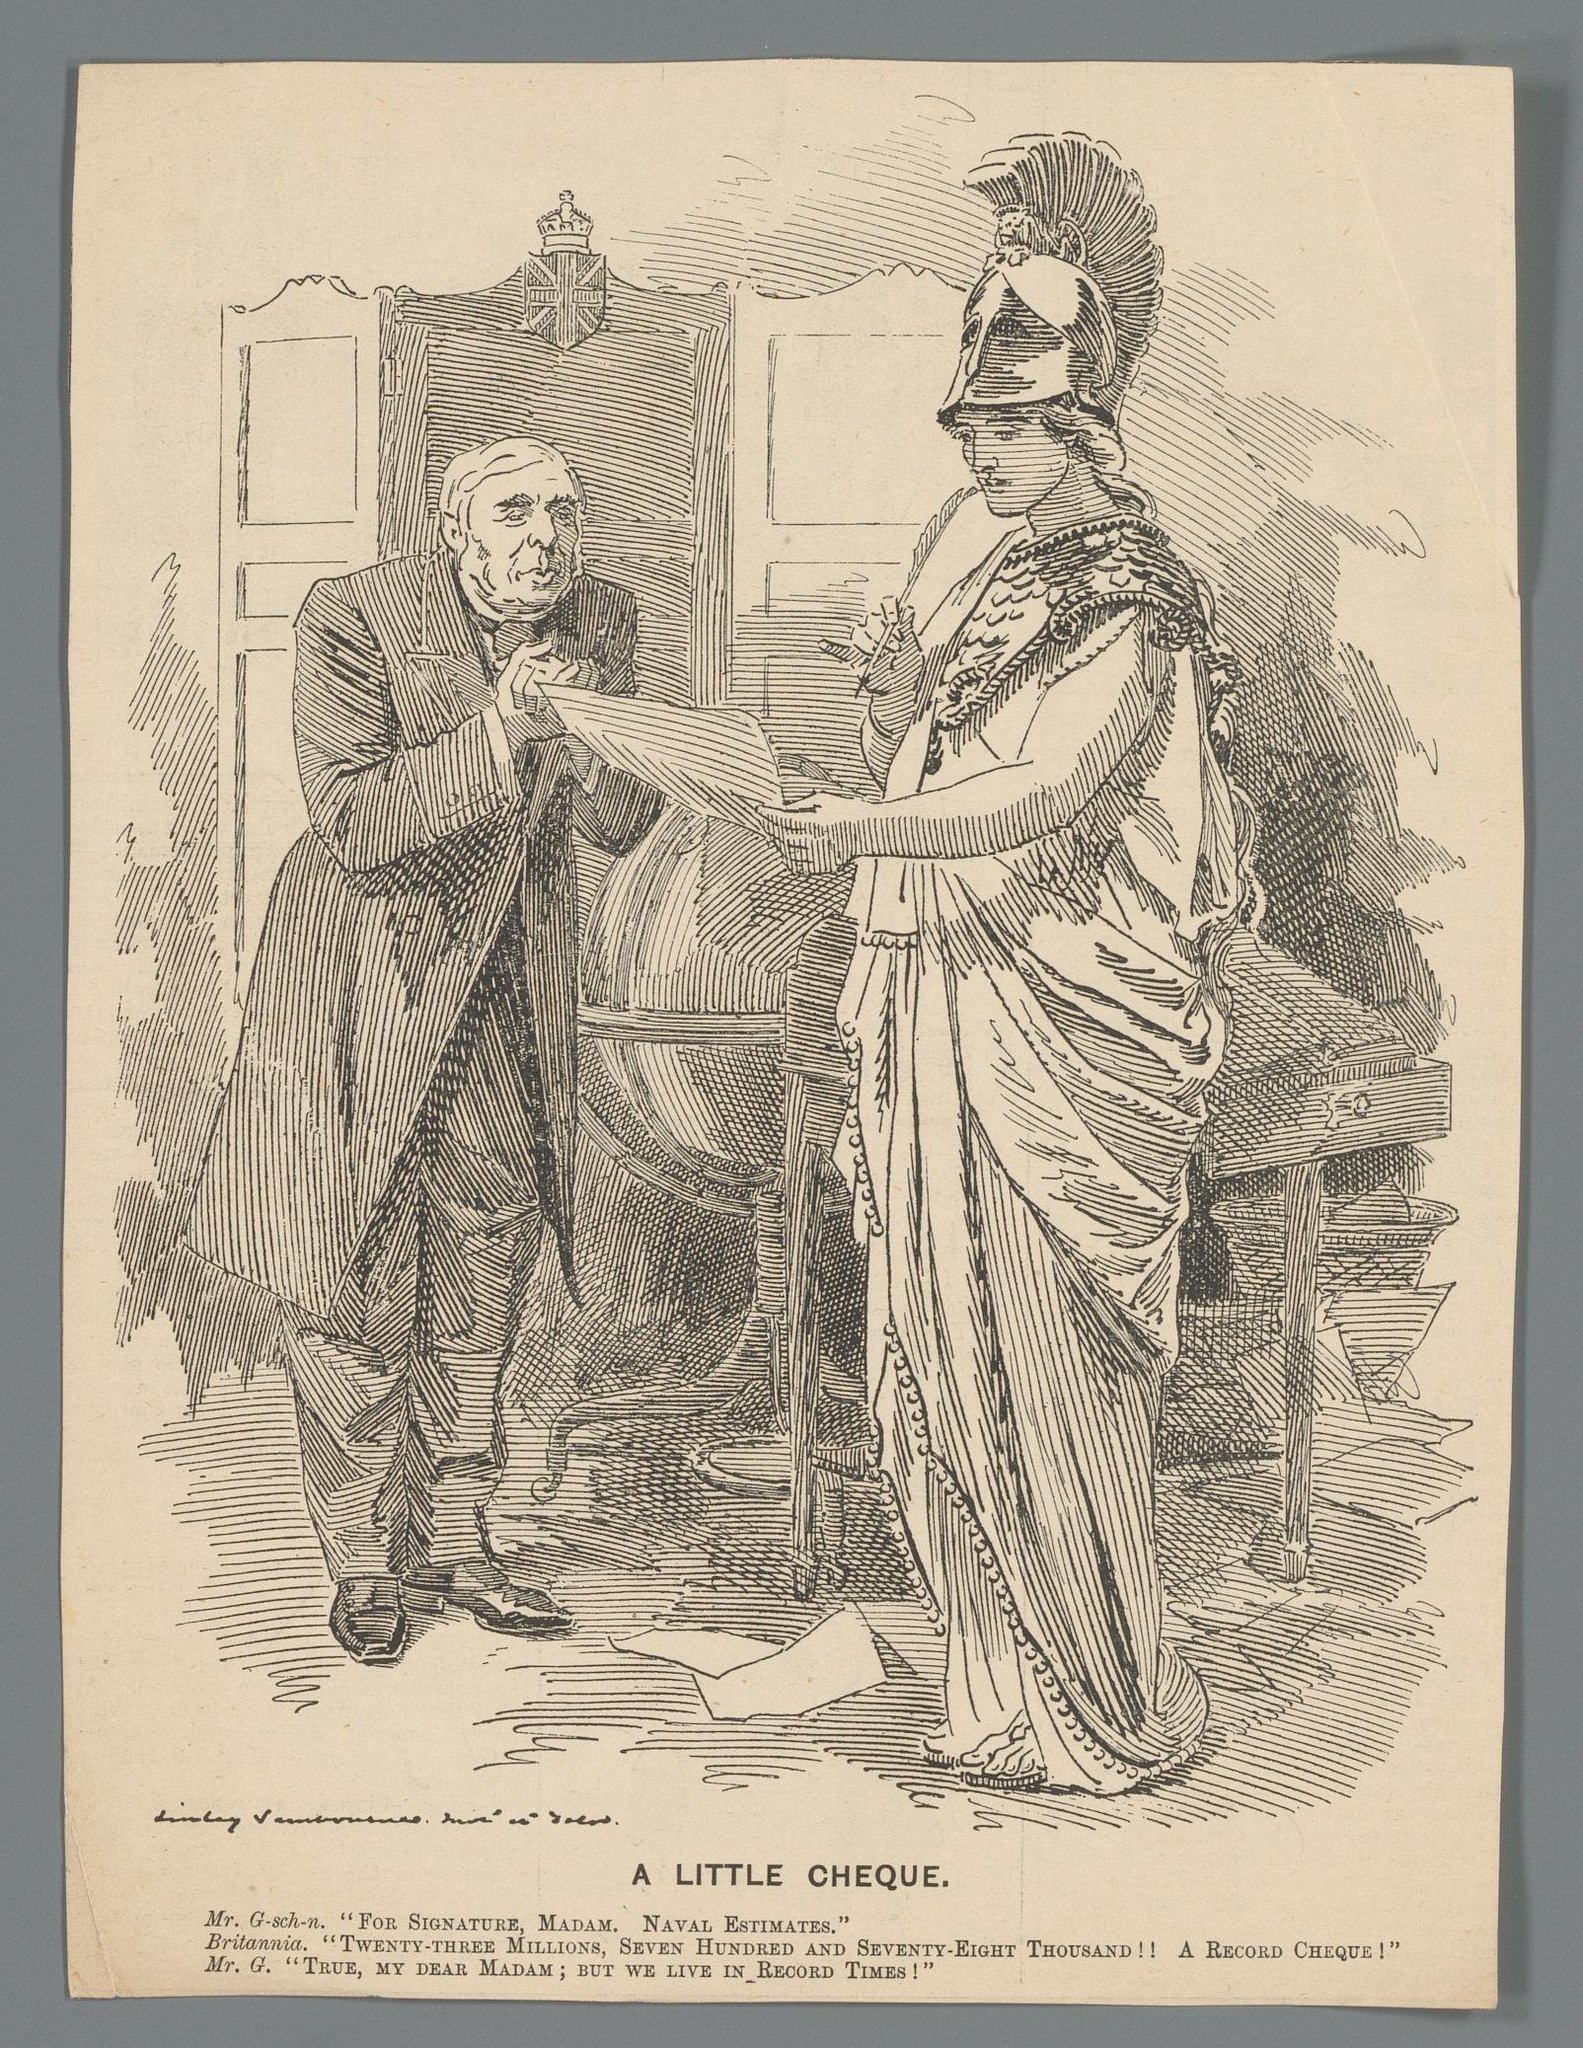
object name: cartoon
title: George Goschen en Britannia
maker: edward linley sambourne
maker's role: draughtsman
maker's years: 1844-1910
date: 1898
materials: paper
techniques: line block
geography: england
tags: politician, personifications of countries, nations, states, districts, etc., political caricatures and satires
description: George Goschen, lord Commissioner of the Admiralty, overhandigt de rekening voor de kosten van de marine aan Britannia, de Britse maagd. Spotprent uit het Engelse satirische tijdschrift Punch, 1898.